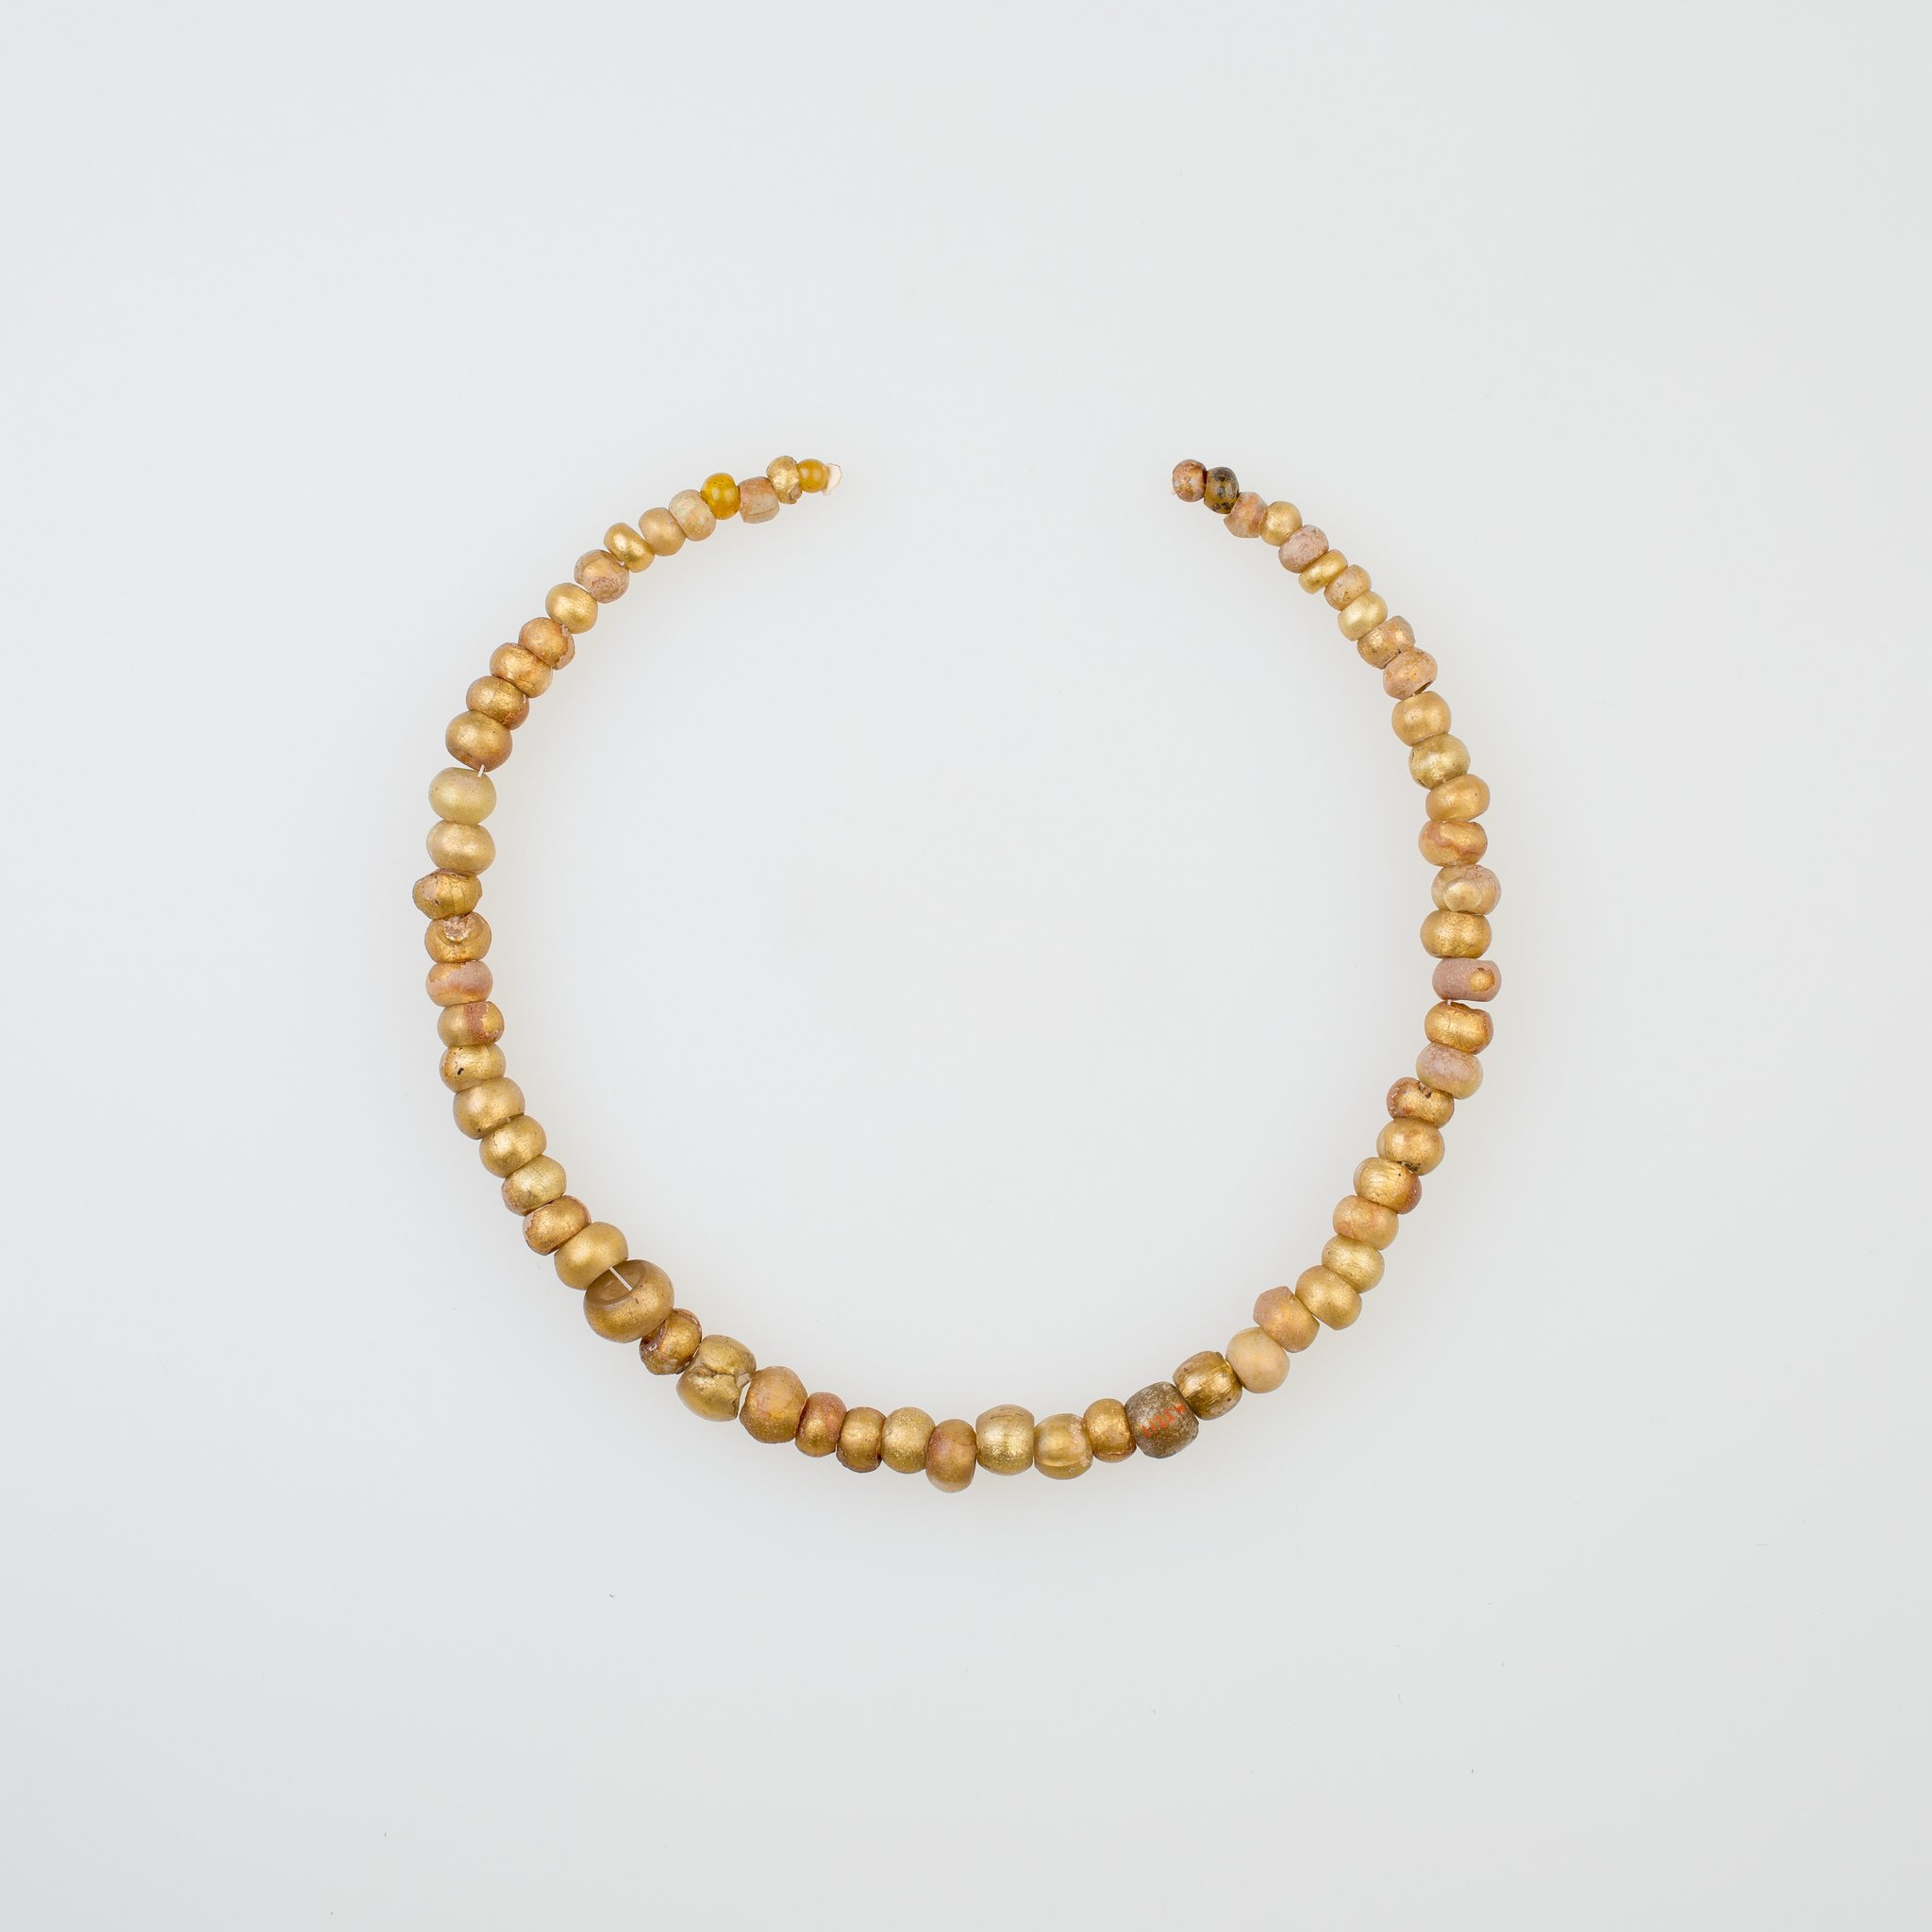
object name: necklace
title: String of 65 Beads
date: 200 BCE-200 CE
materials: glass, gold foil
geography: egypt